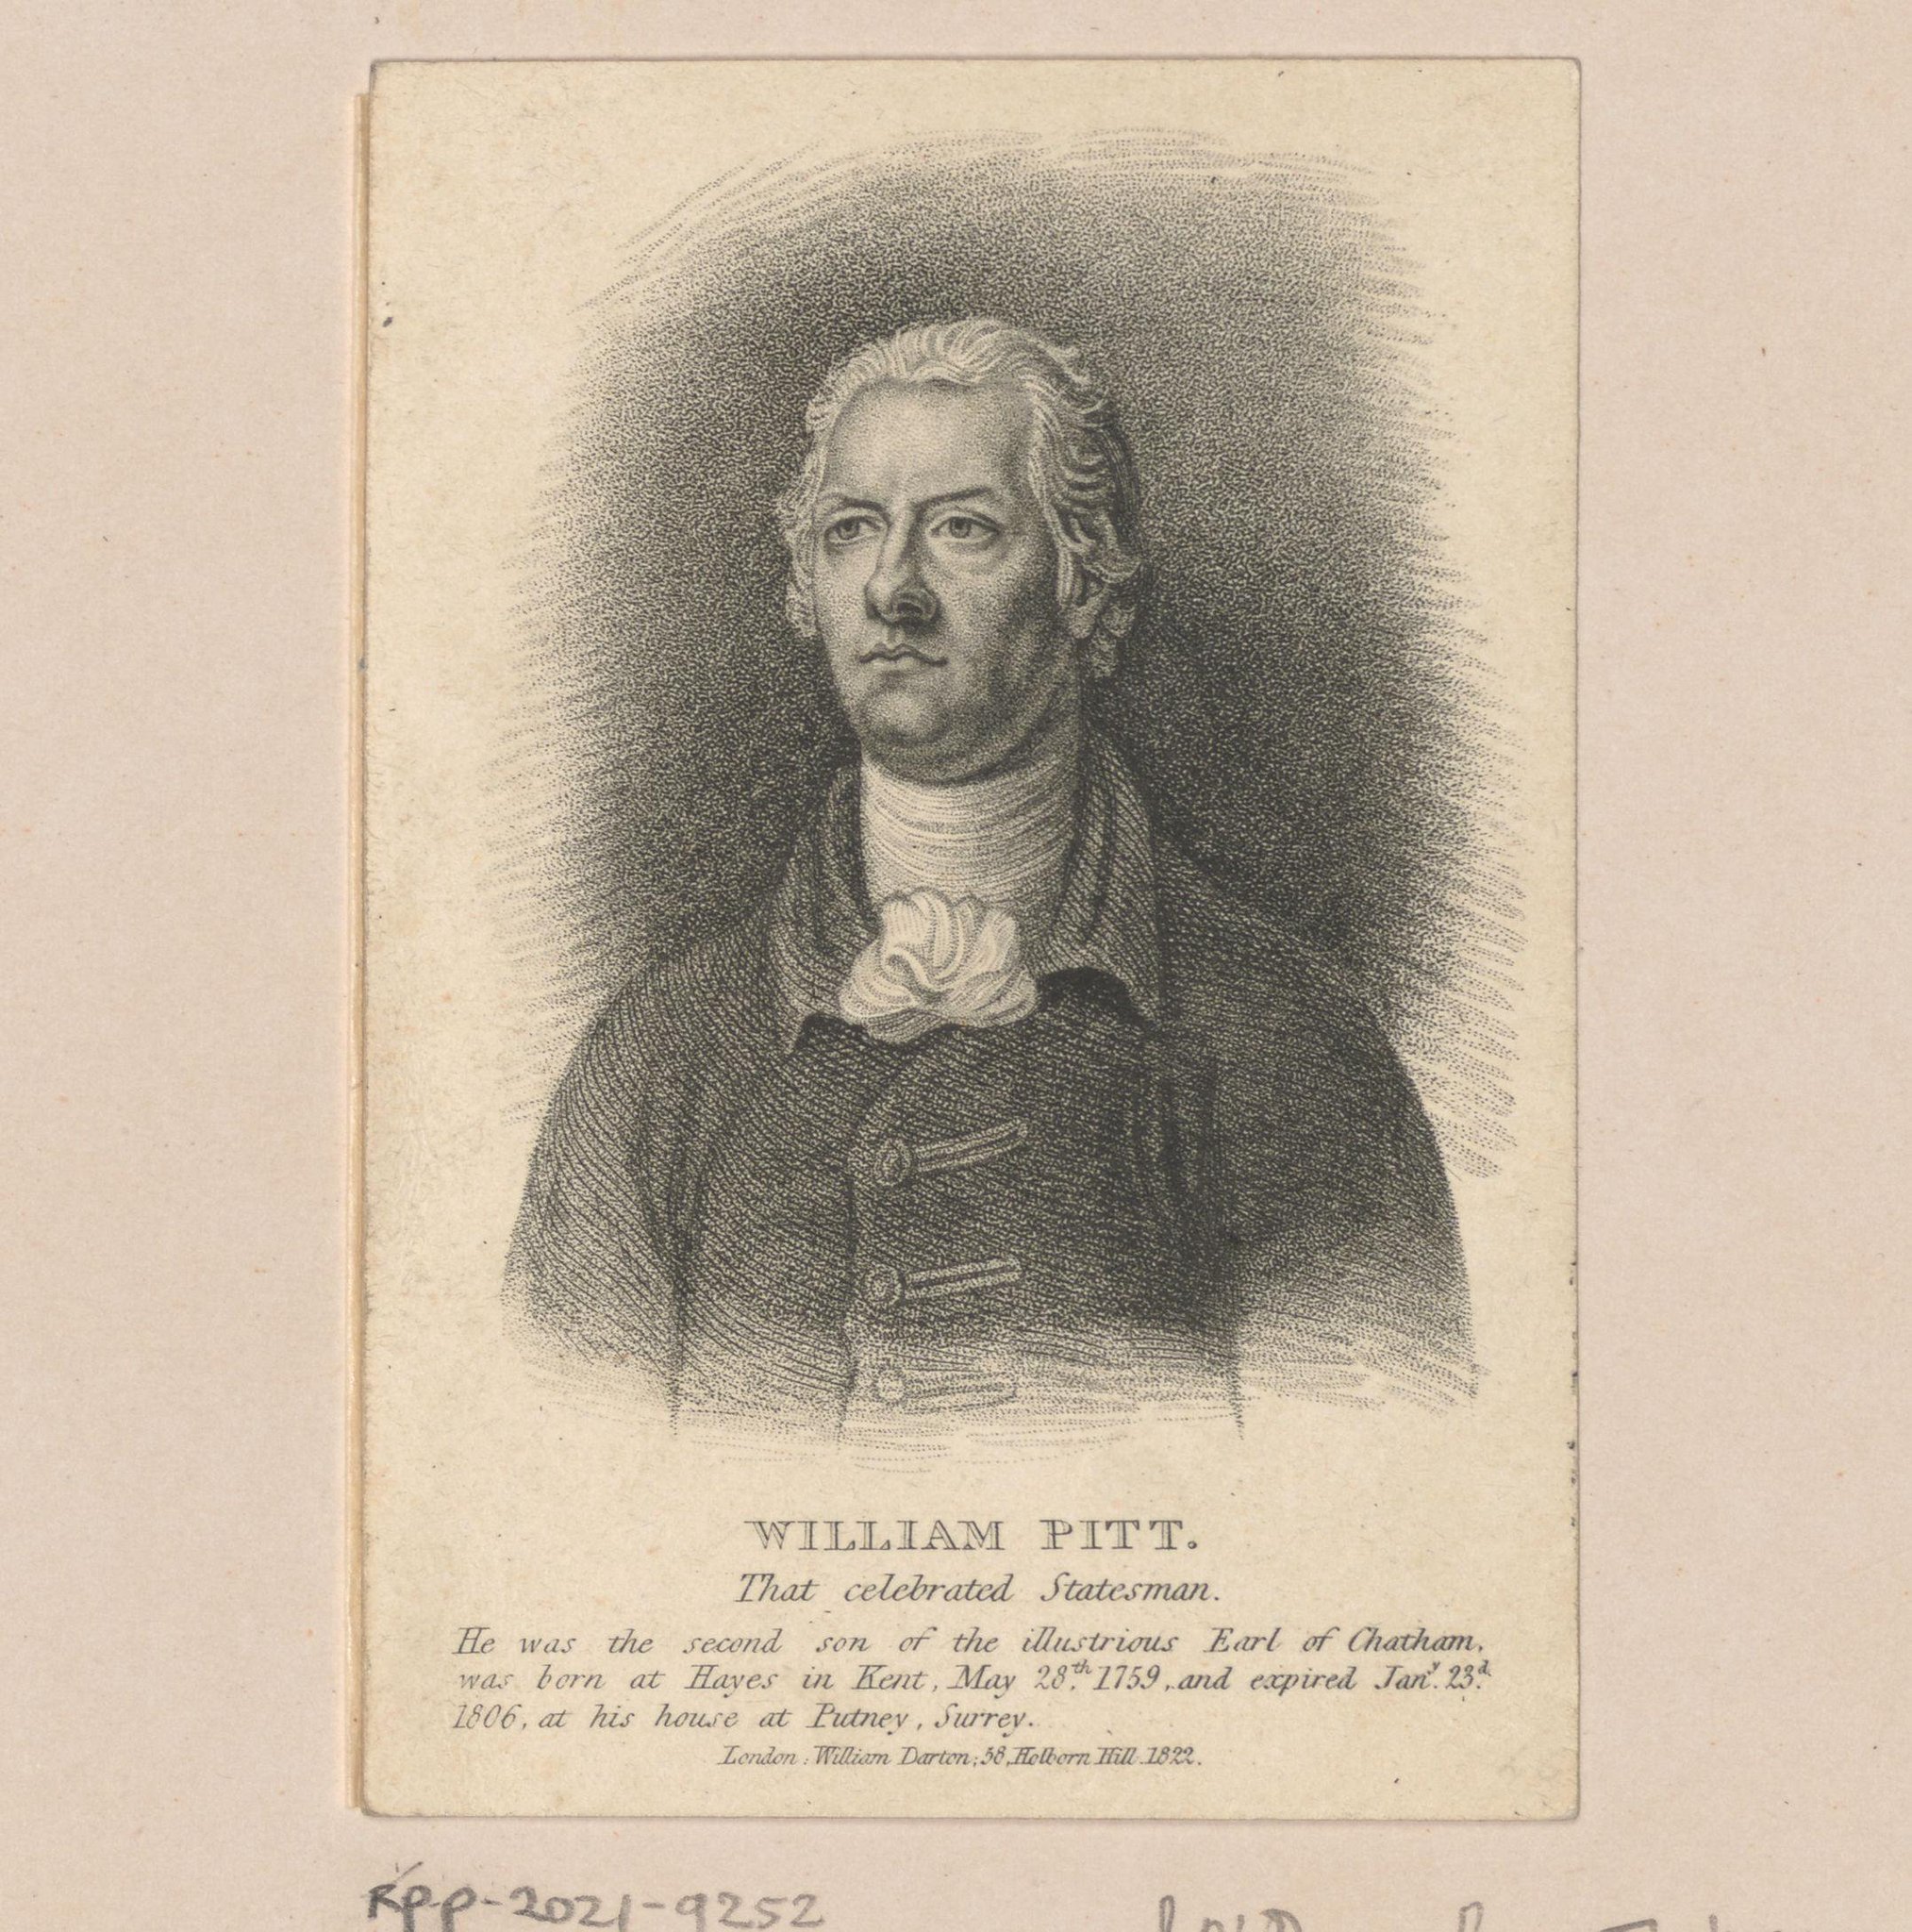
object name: print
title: Portret van William Pitt II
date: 1822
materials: paper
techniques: engraving, roulette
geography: london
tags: london, politician, adult man, historical persons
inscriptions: date